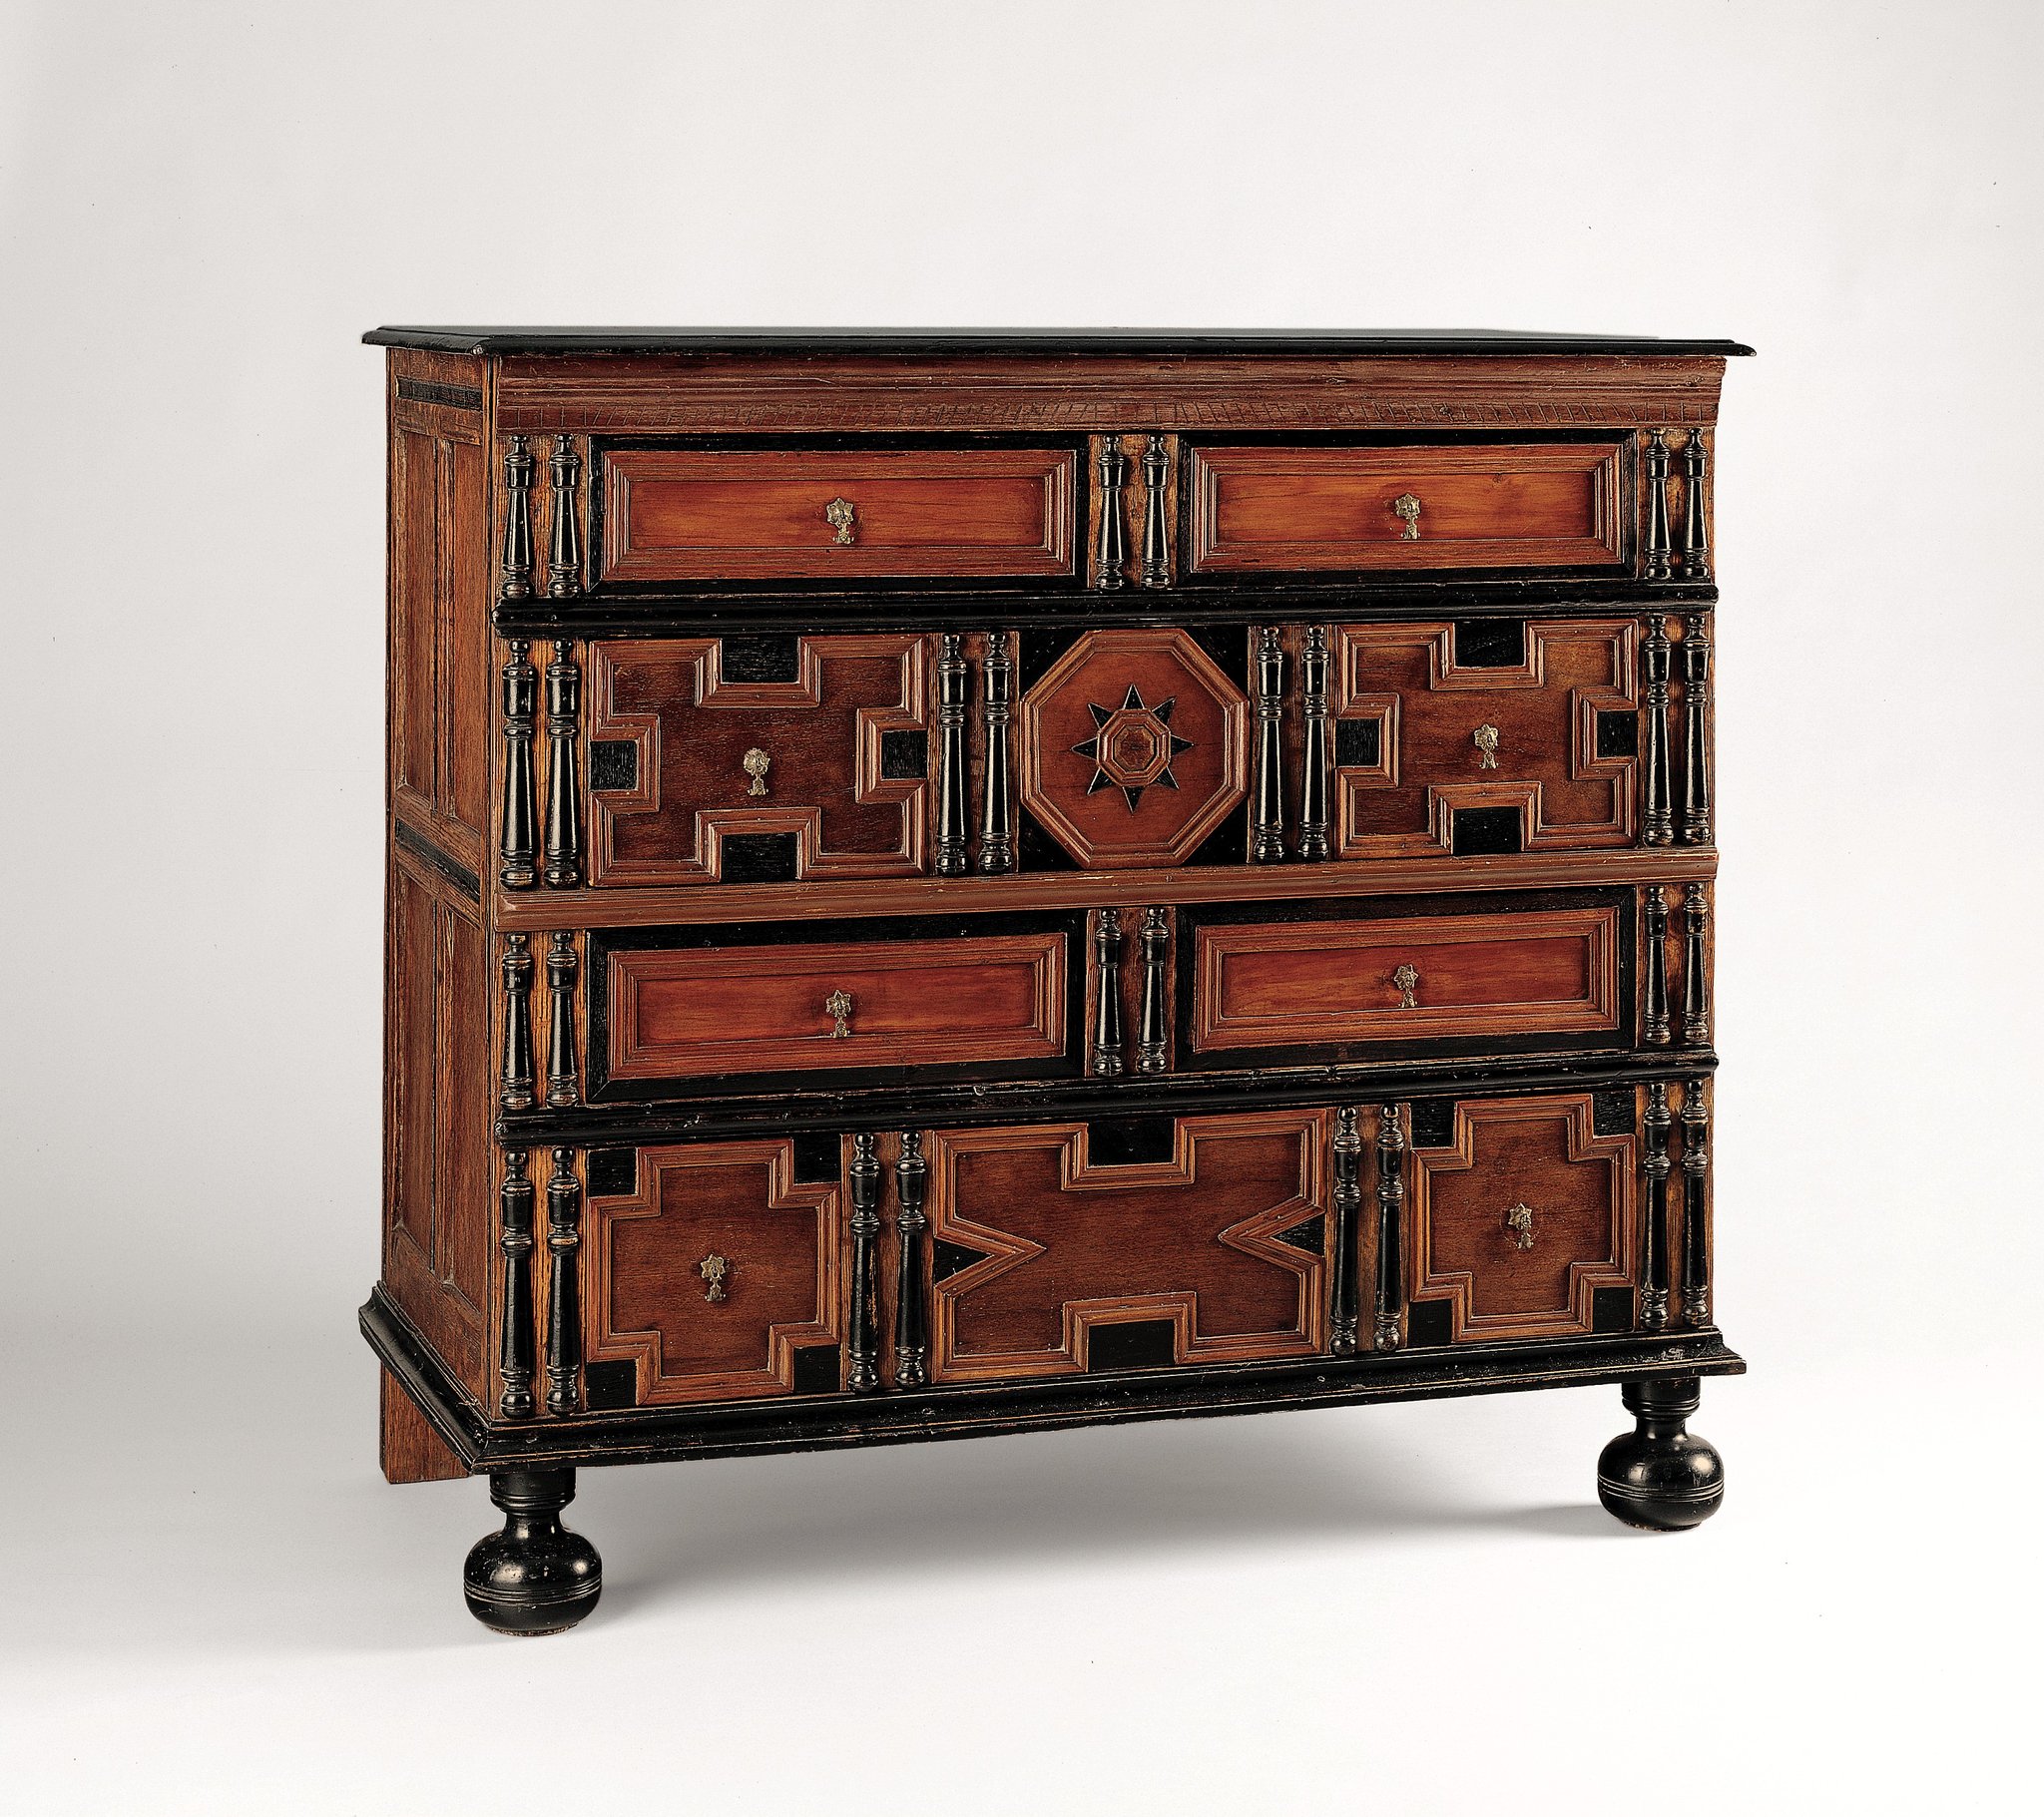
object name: chest of drawer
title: Chest of Drawers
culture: american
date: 1675-1700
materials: wood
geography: united states